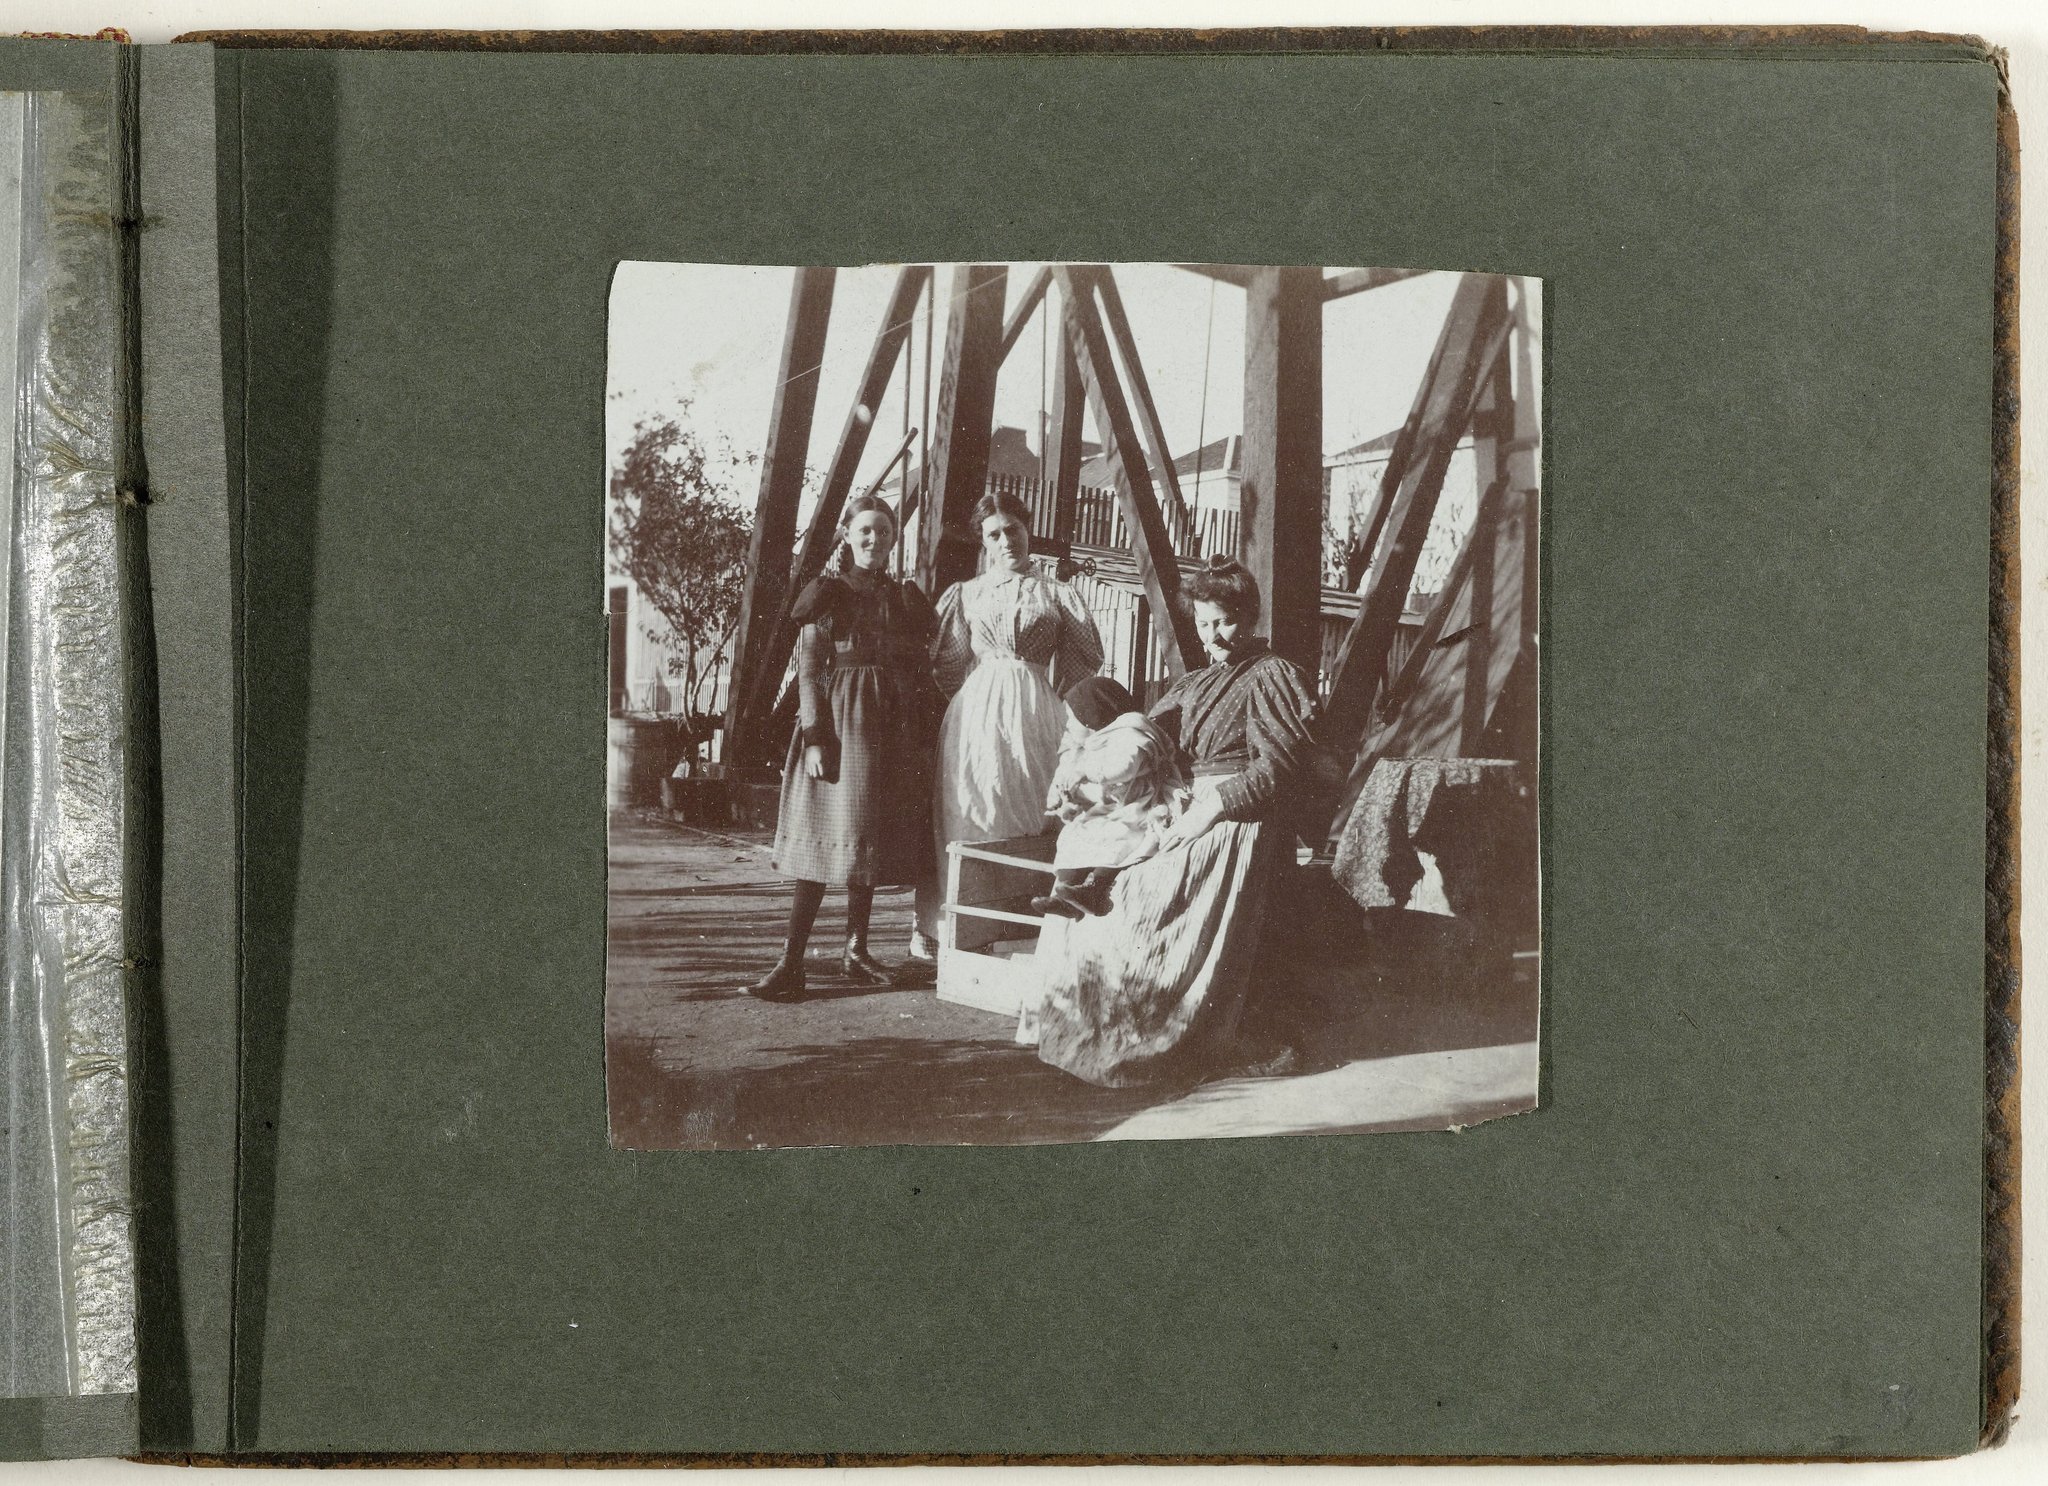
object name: album leaf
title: Groepsportret van drie vrouwen en een kind aan de voet van een boortoren, Verenigde Staten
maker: Anonymous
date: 1900-1920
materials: paper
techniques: gelatin silver print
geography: united states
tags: derrick ~ oil, mother and child(ren), woman and child(ren) (family group), anonymous historical persons portrayed in a group, in a group-portrait, united states of america